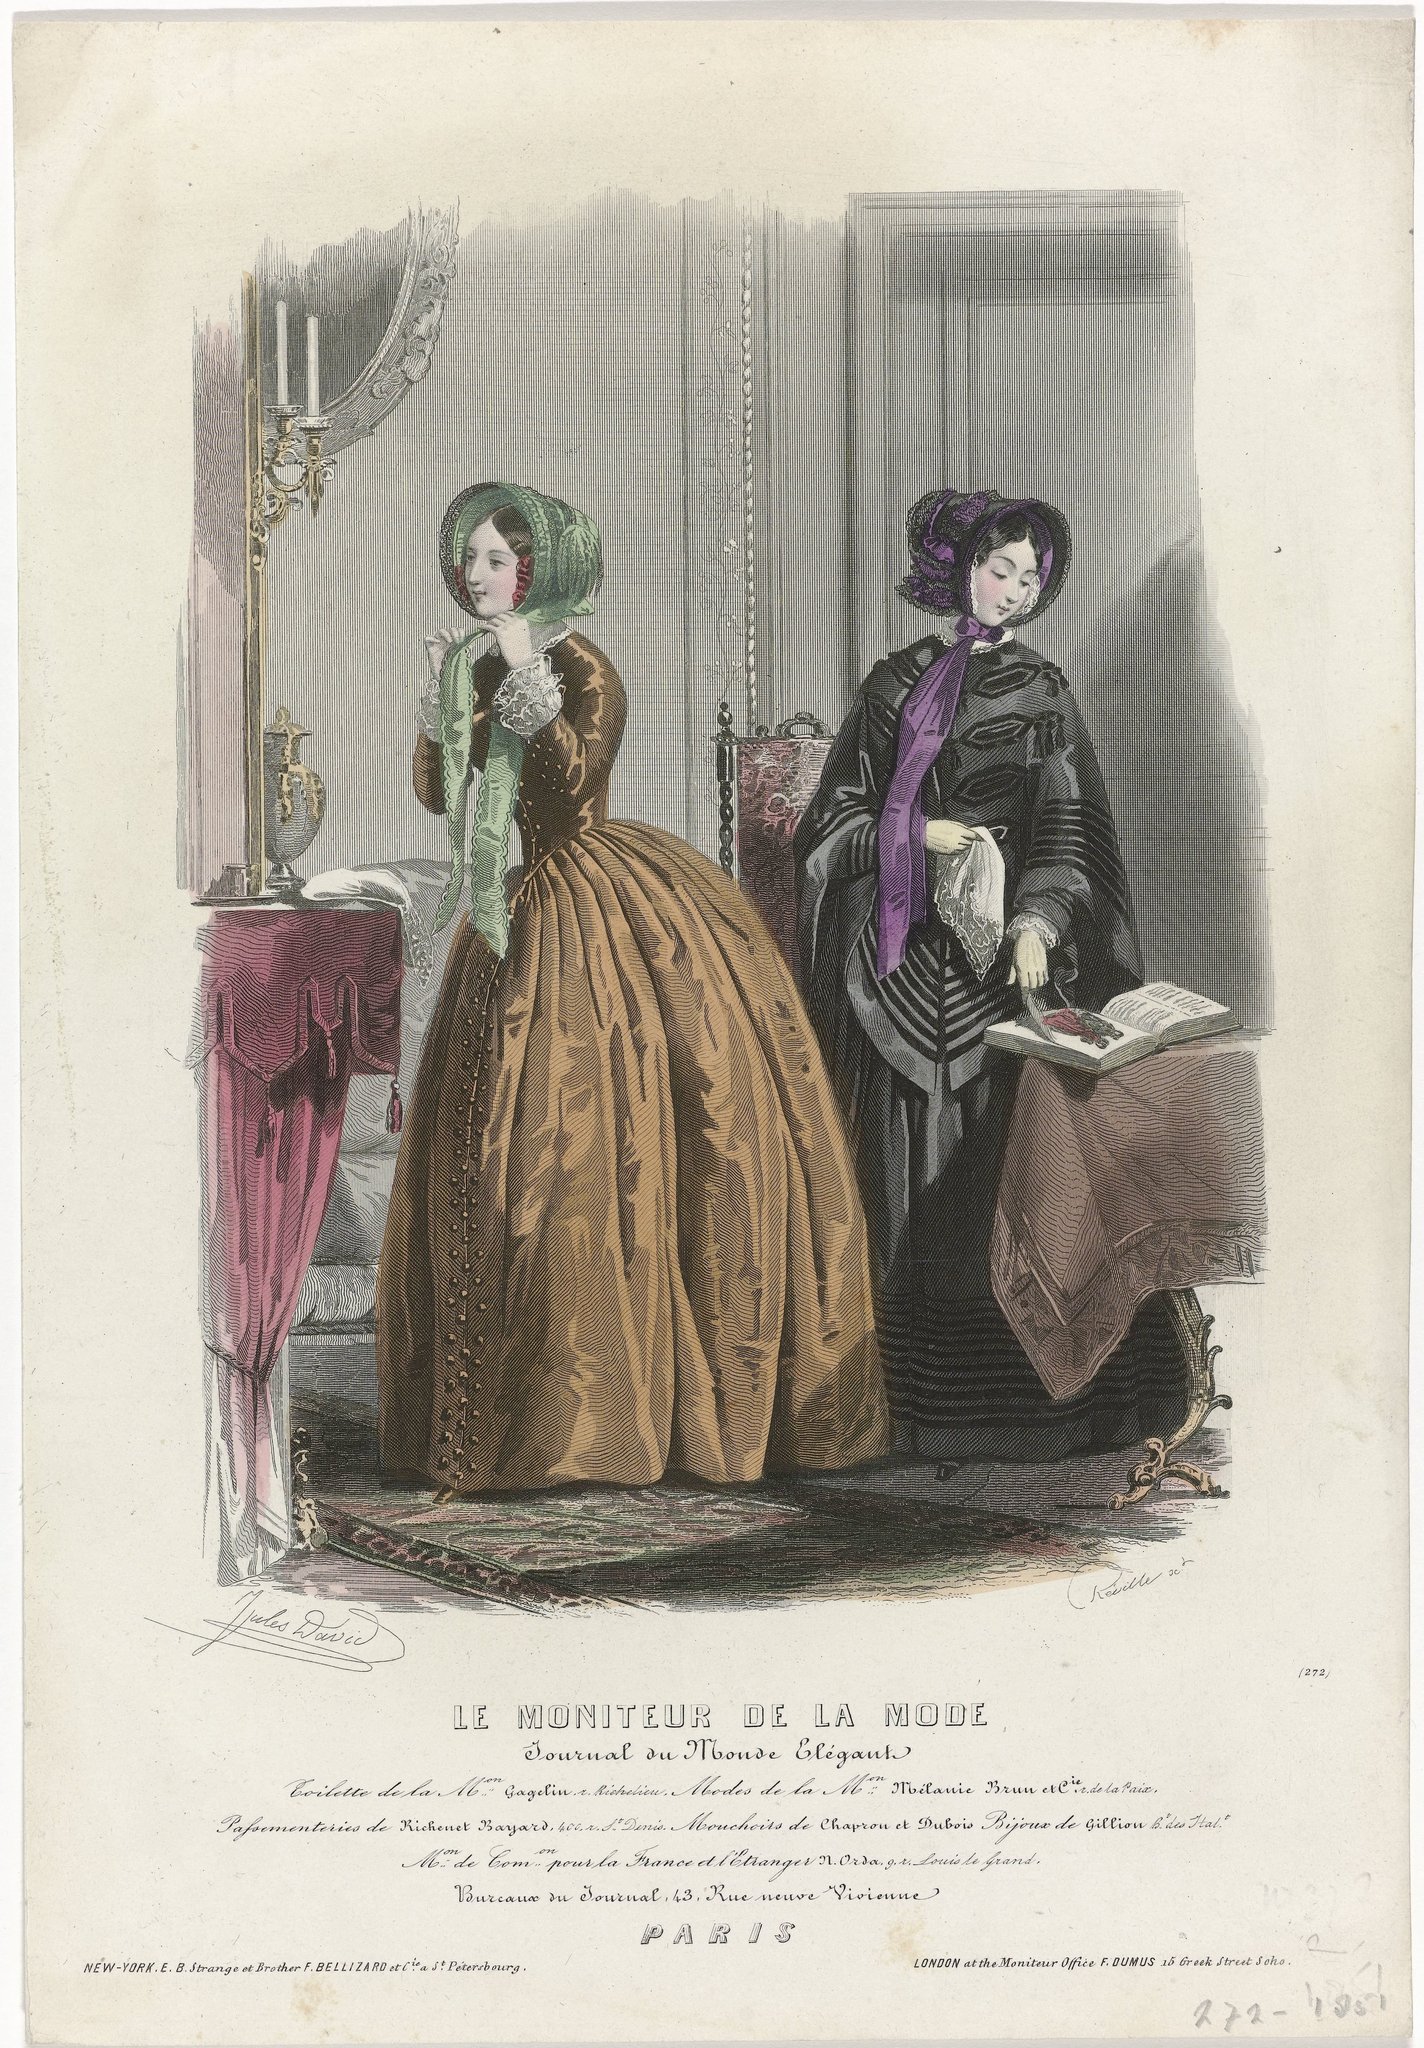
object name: fashion print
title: Le Moniteur de la Mode, 1851, No. 272: Toilettes de la Maison Gagelin (...)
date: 1851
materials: paper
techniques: hand coloring, engraving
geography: paris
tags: diadem, tiara (+ women's clothes), ornamental parts of clothing (+ women's clothes), head-gear: hat (+ dressing, putting on clothes), clothing for the upper part of the body (mantelet) (+ women's clothes), fashion plates, head-gear: hat (+ women's clothes), skirt (+ women's clothes), book in which illustrations are essential - mm - book open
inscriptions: address: ‘Bureaux du Journal, 43, Rue neuve Vivienne. Paris. / New-York. E.B. Strange et Brother. F. Bellizard et C.ie à S.t Pétersbourg. / London at the Moniteur Office. F. Dumus 15 Greek Street Soho.’, caption: ‘Toilettes de la M"on Gagelin. r. Richelieu. Modes de la M"on Mélanie Brun et C.ie, r. de la Paix, Passementeries de Richenet Bayard. 400,r. S.t Denis. Mouchoirs de Chapron et Dubois Bijoux de Gillion B.t des Ital.t M"on de Comön pour la France et l'Etranger N.Orda, g.r. Louis le Grand.’, title: ‘Le Moniteur de la Mode. / Journal du Monde Elégant’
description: Twee vrouwen in een interieur. Één vrouw is bezig haar hoed op te doen; de ander bekijkt een ingebonden modetijdschrift wat op tafel ligt. Volgens het onderschrift: 'toilettes' van Maison Gagelin. Hieronder enkele regels reclametekst voor verschillende producten. Prent uit het modetijdschrift Le Moniteur de la mode (1843-1913).